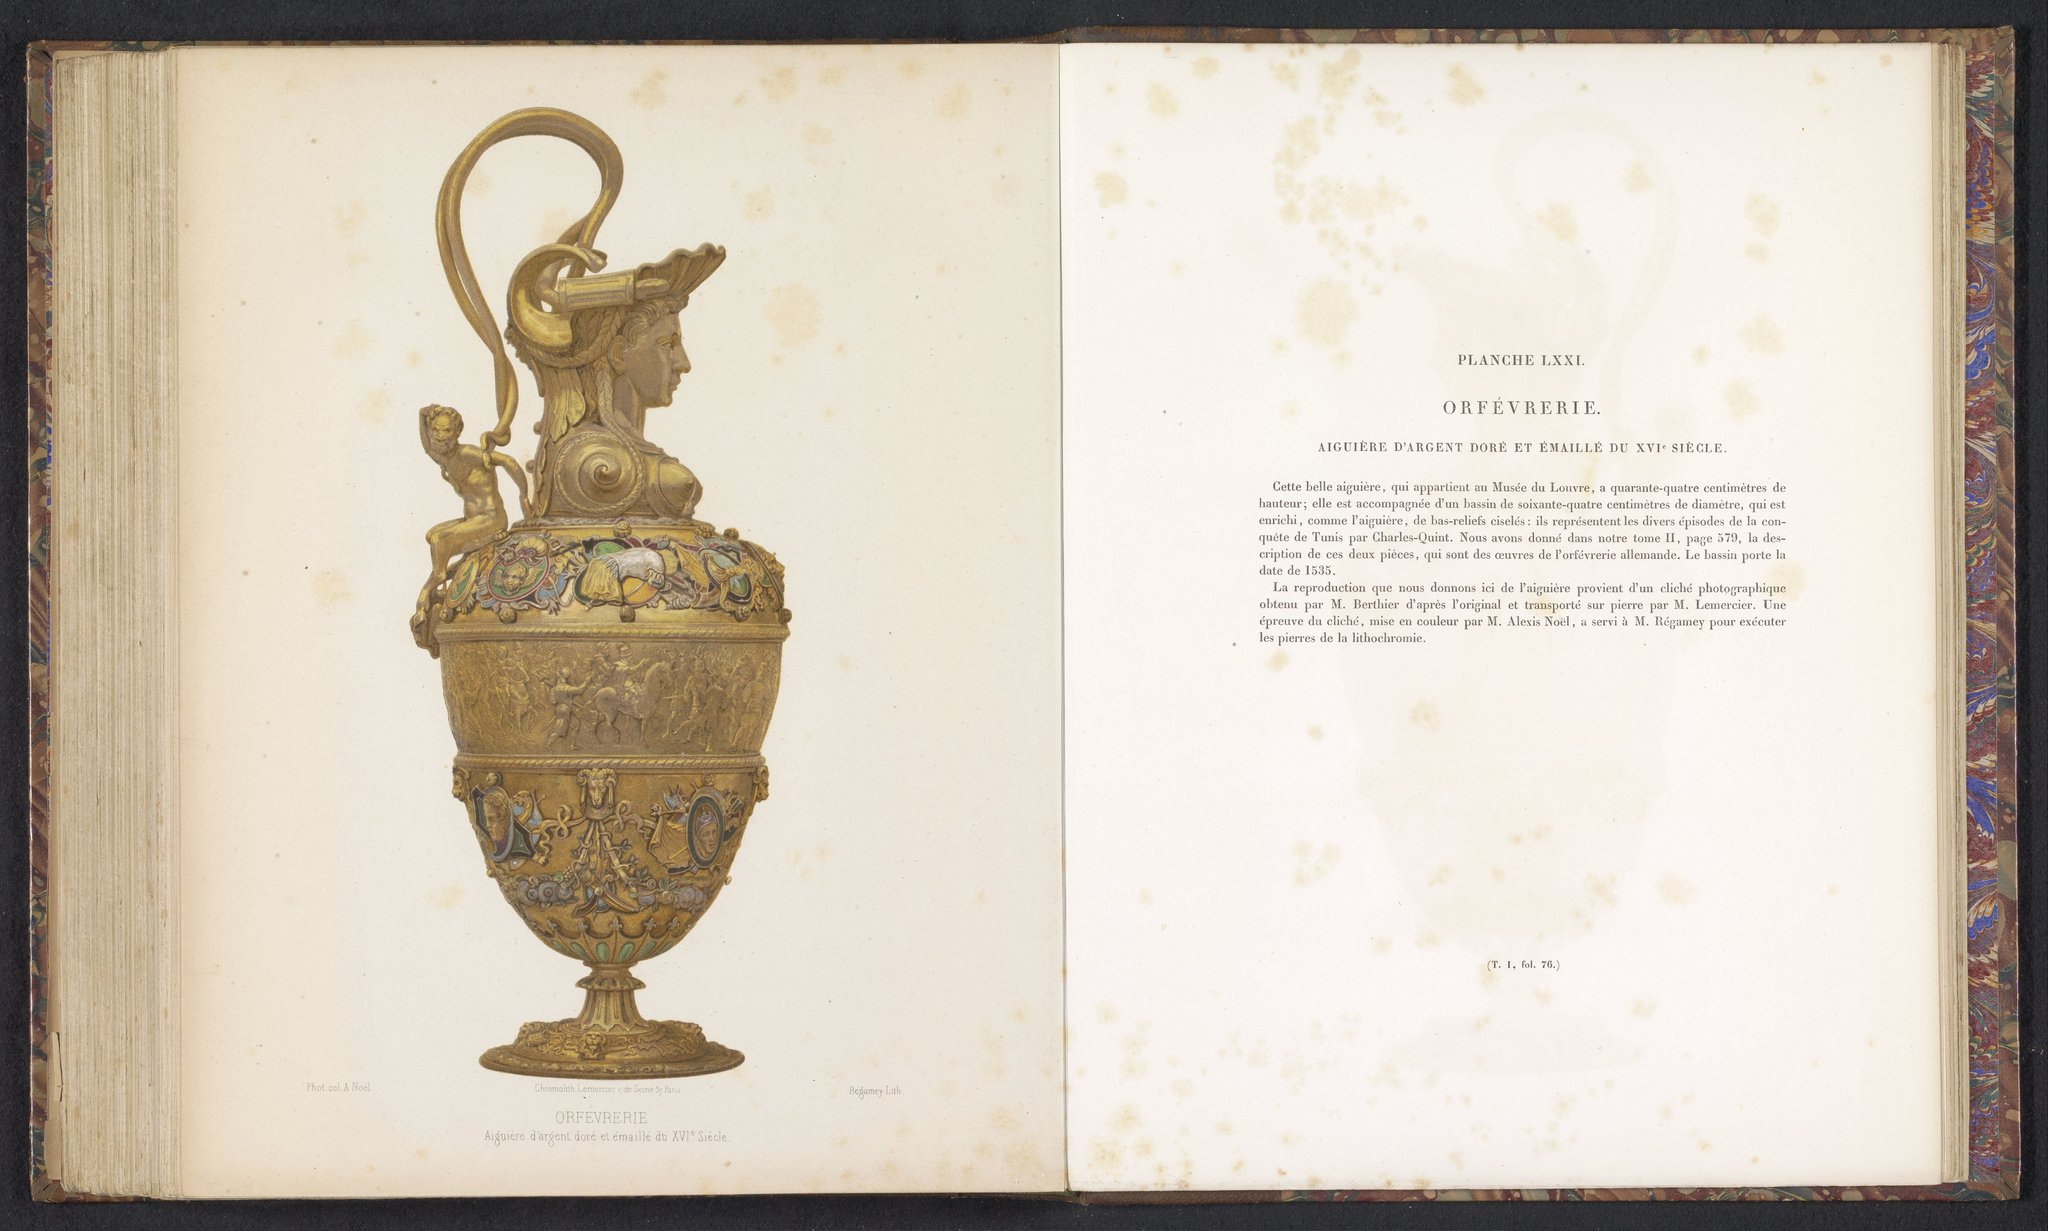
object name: print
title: Lampetkan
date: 1859-1864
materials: paper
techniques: chromolithography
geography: paris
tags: jug and basin; wash-basin